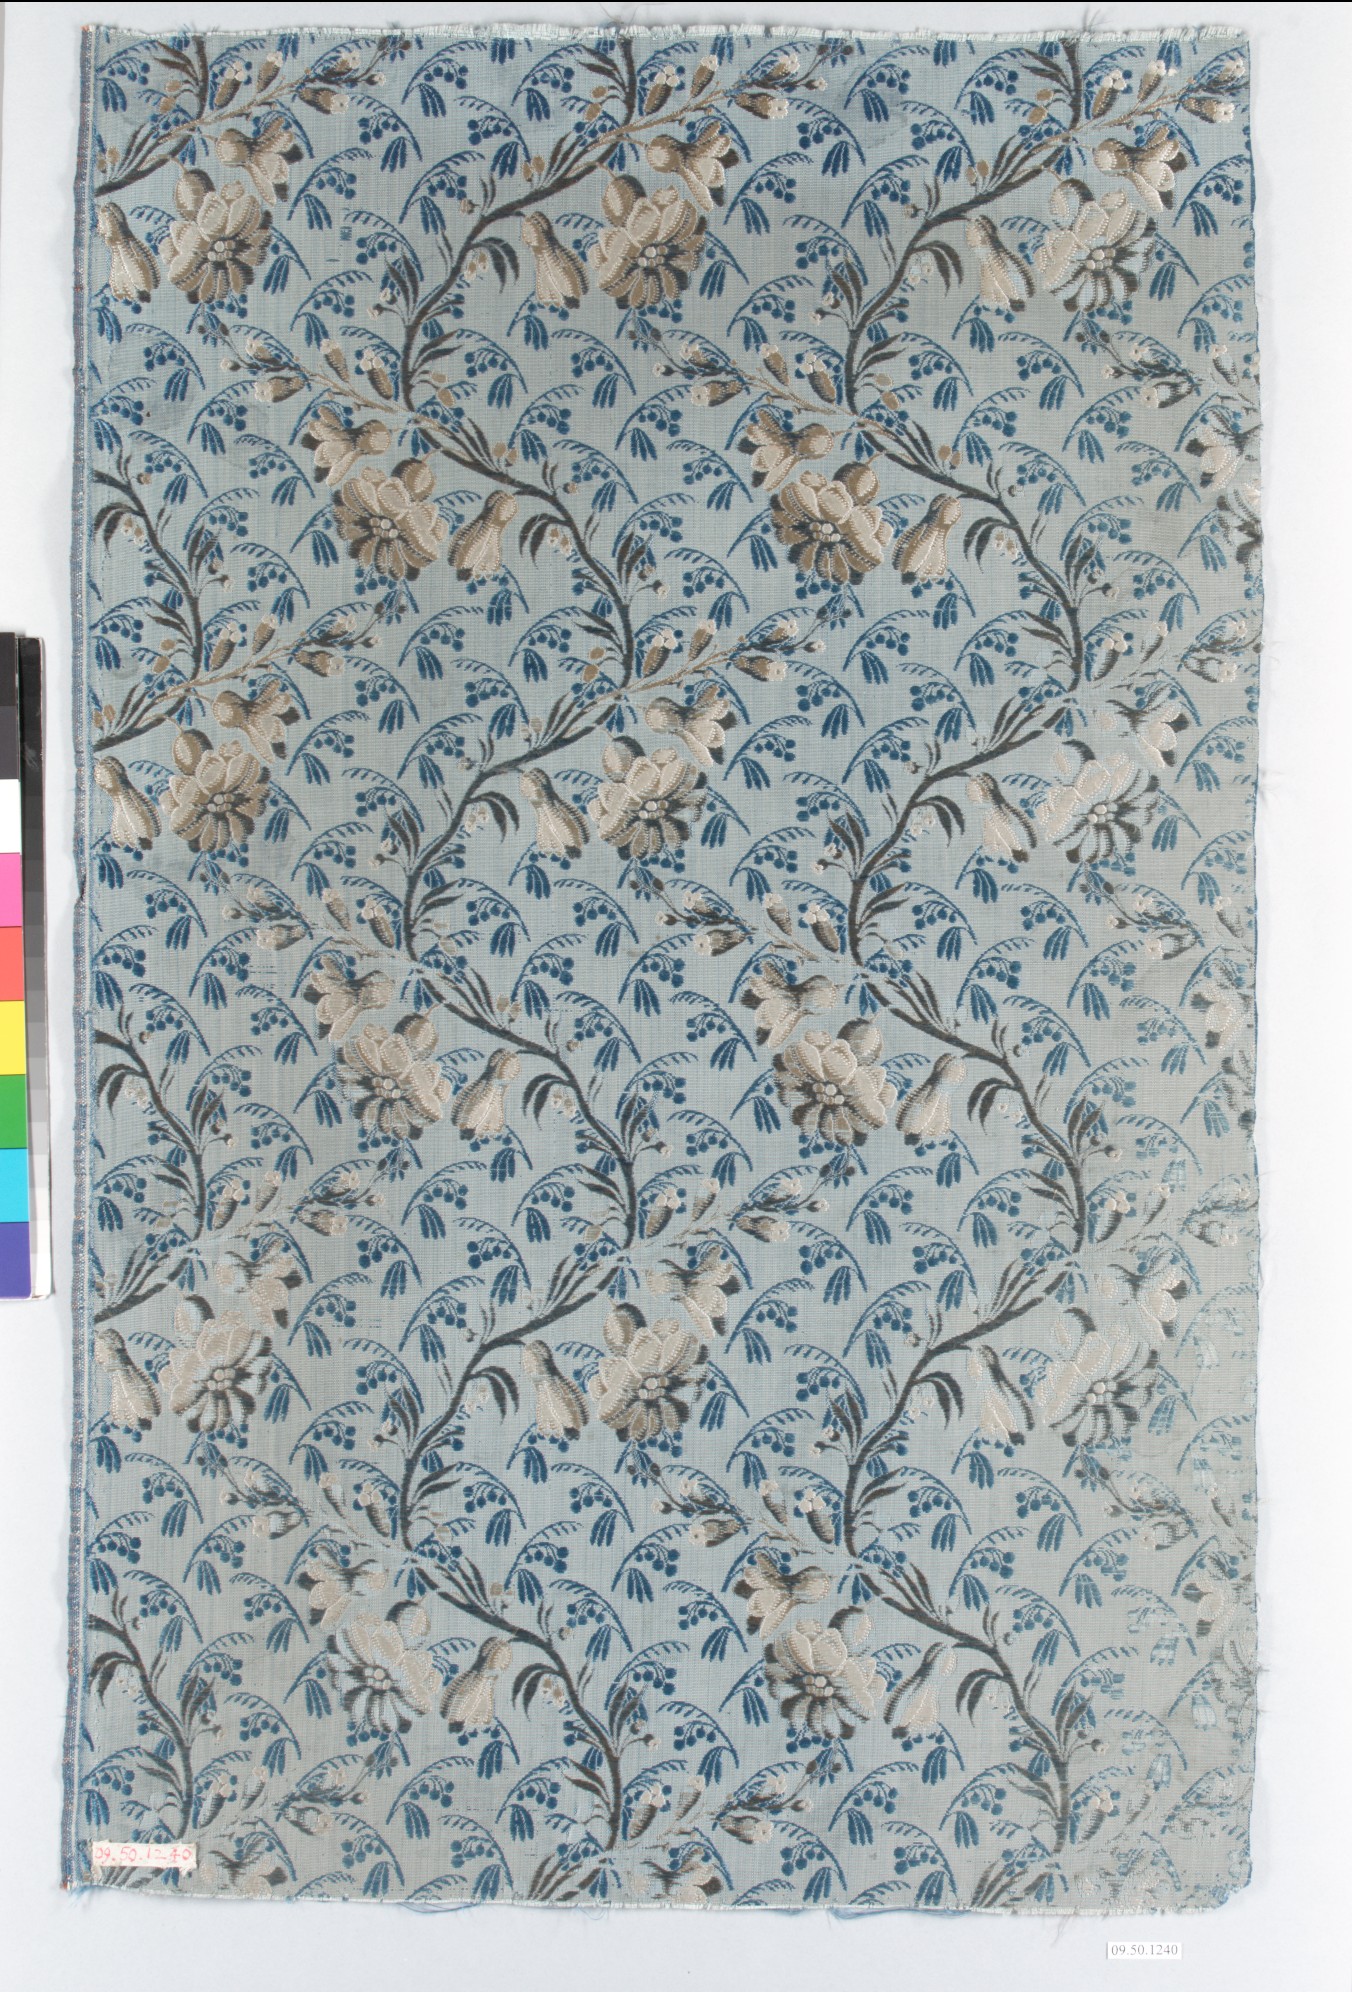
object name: piece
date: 1750-1760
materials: silk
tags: flowers,leaves